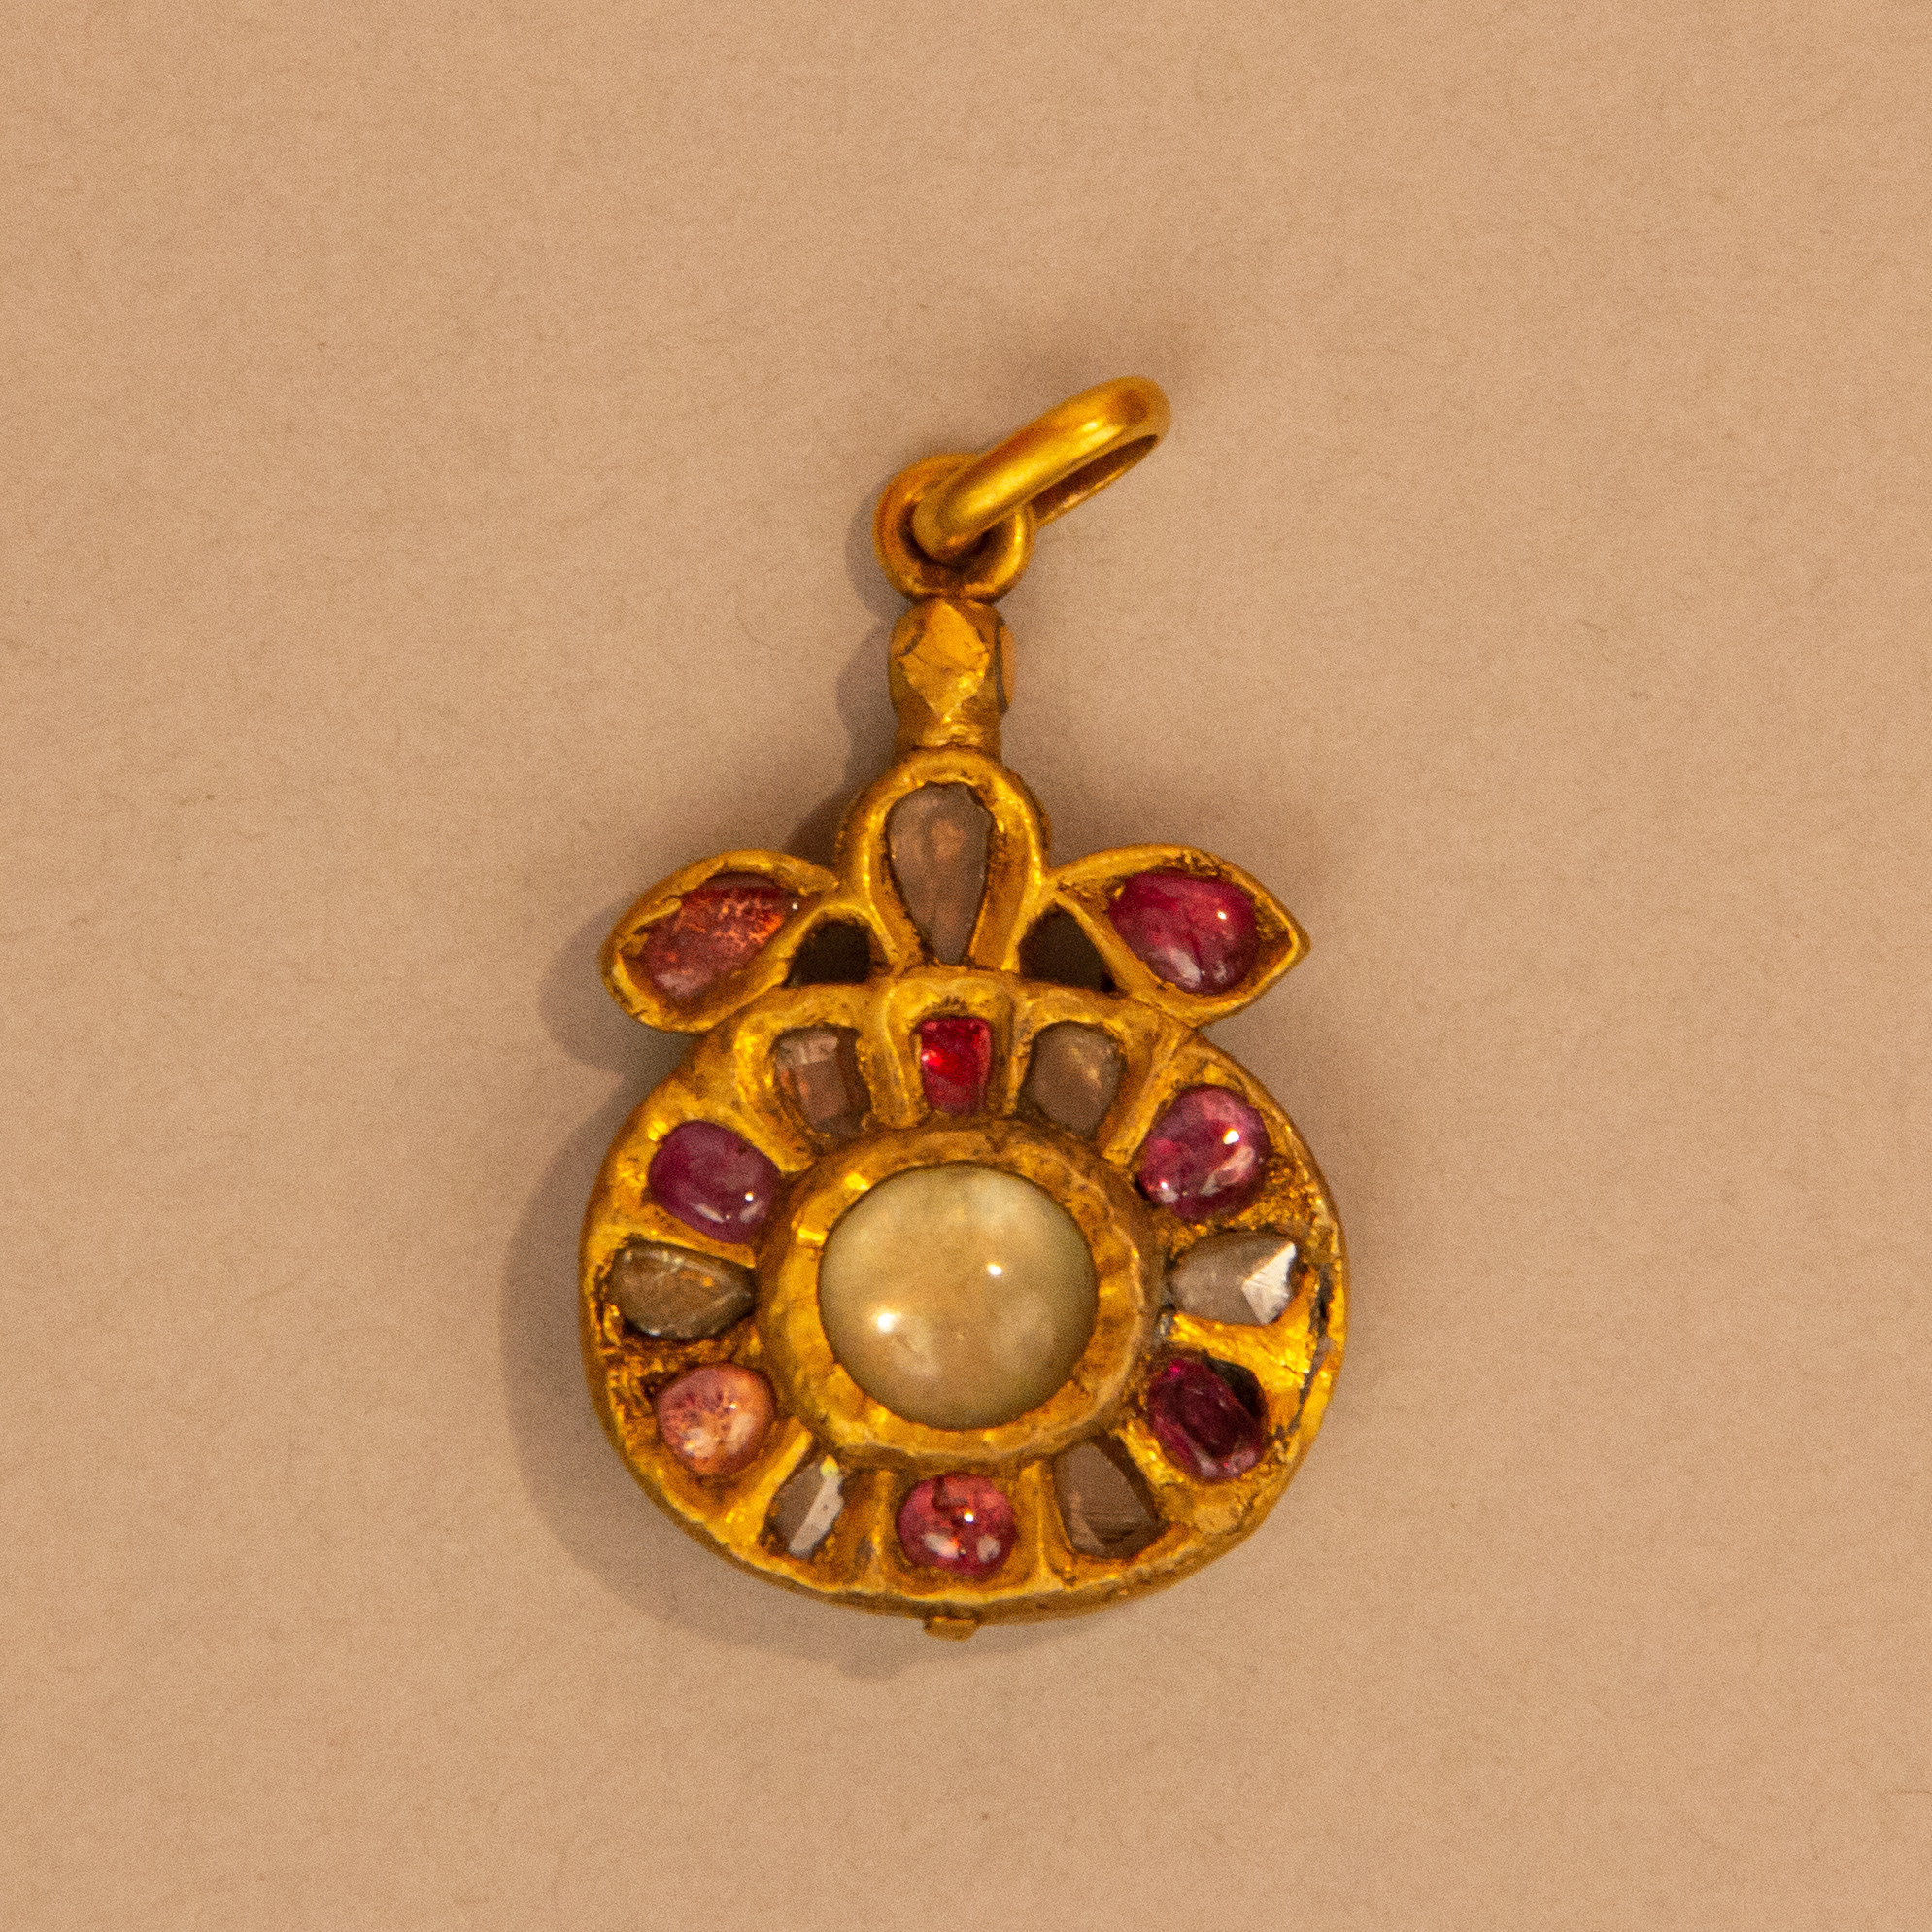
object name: pendant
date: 1701-1900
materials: gold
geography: northern india